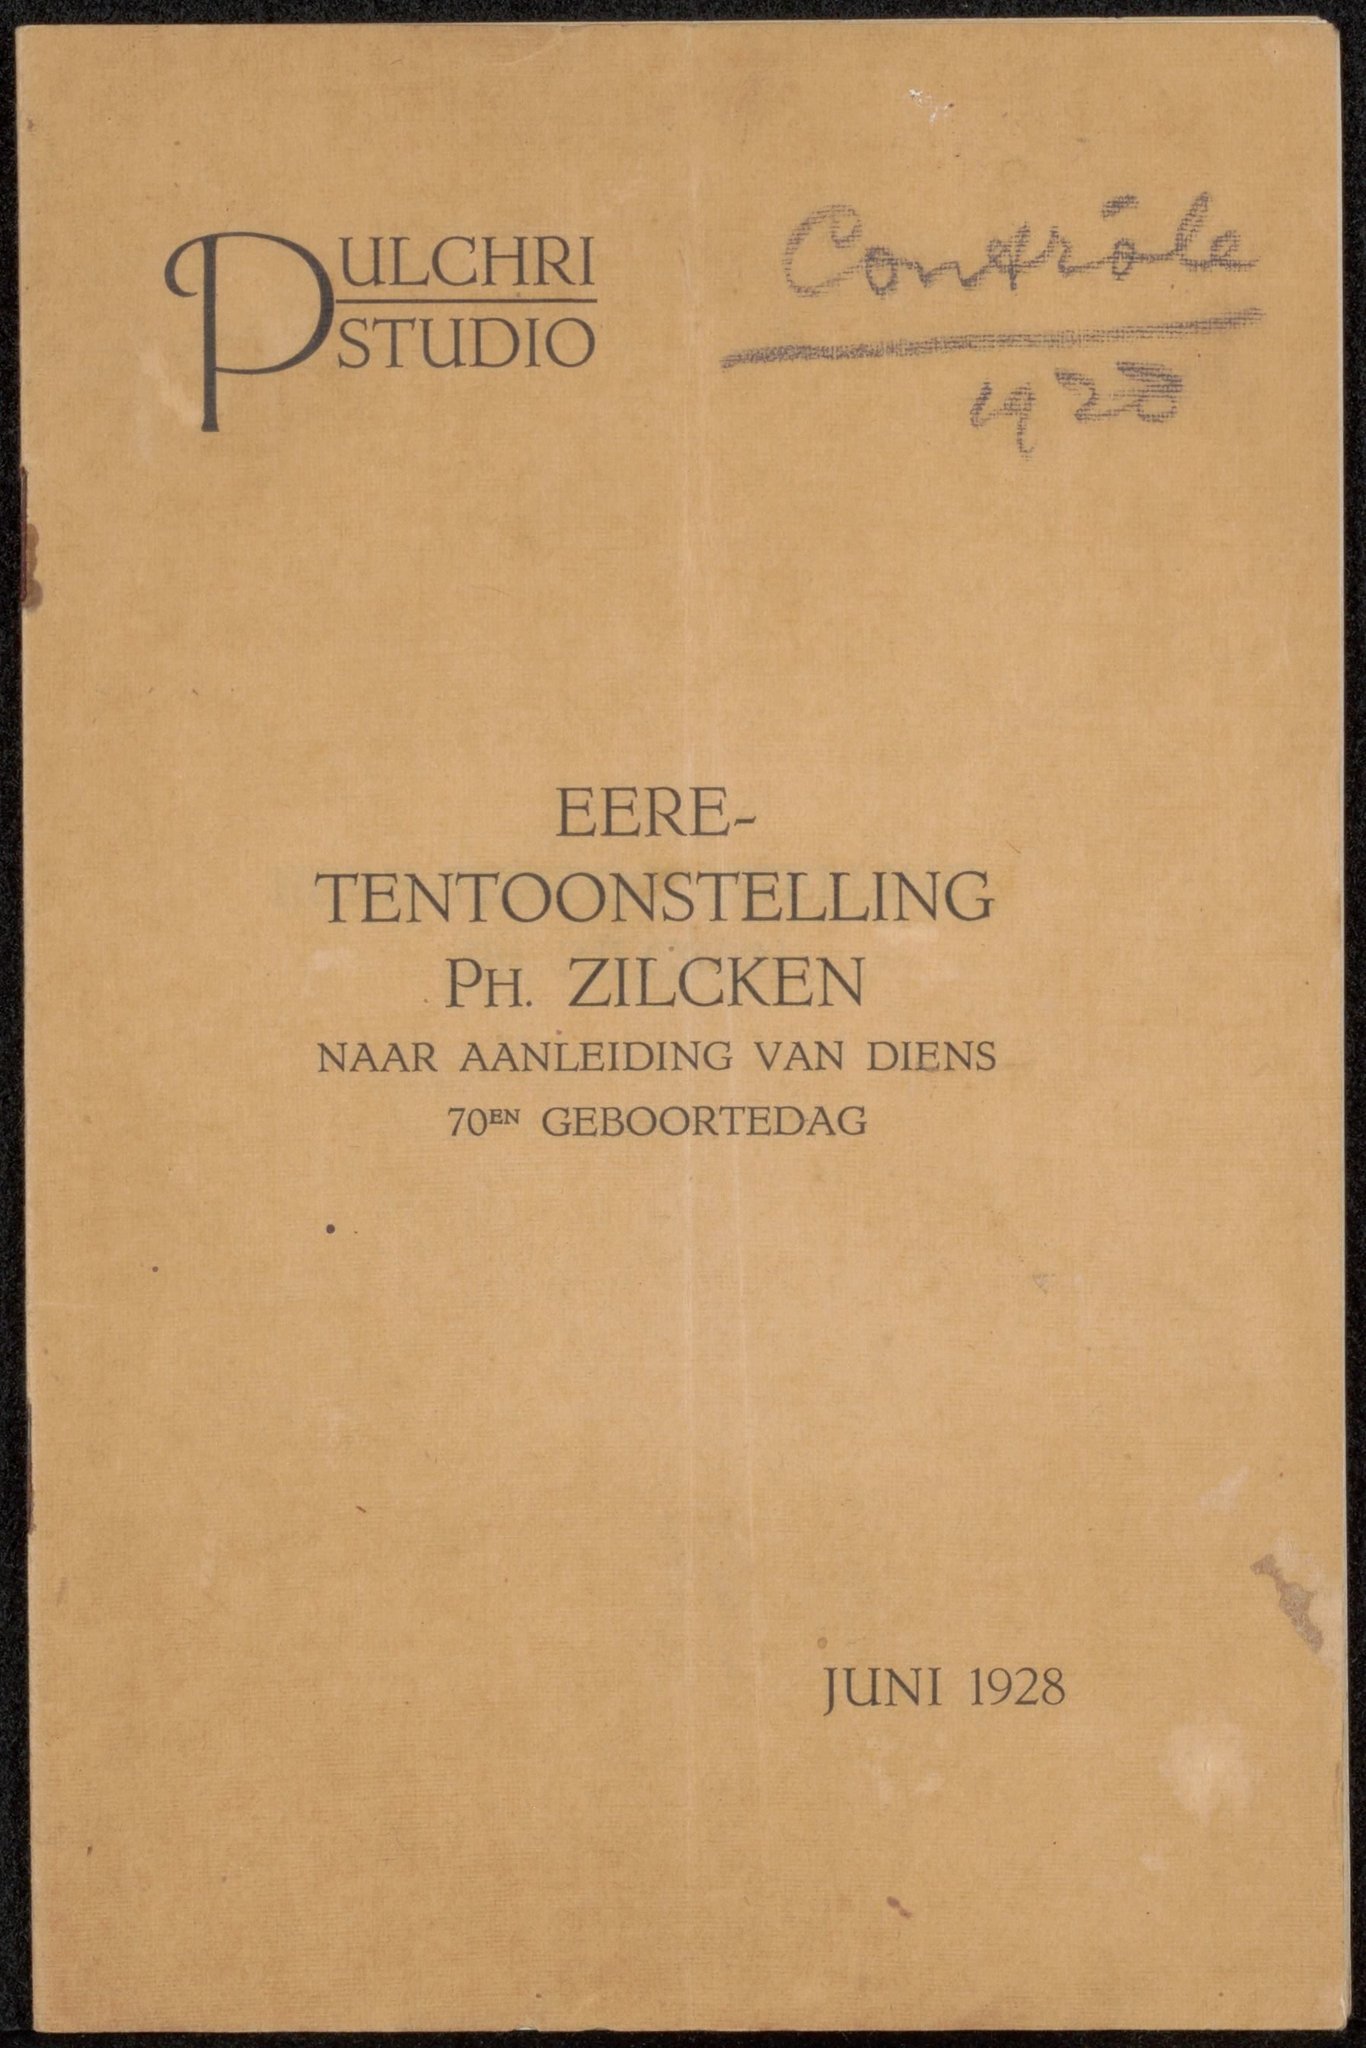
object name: catalog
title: Tentoonstellingscatalogus uit archief Philip Zilcken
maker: pieter anne haaxman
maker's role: journalist, kunstcriticus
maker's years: 1847-1935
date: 1906-1928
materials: ink, paper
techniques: printing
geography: the hague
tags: the hague, painter, draughtsman, philip zilcken, exhibition ~ art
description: Catalogus bevat een aantekening van Philip Zilcken op een los vel papier.